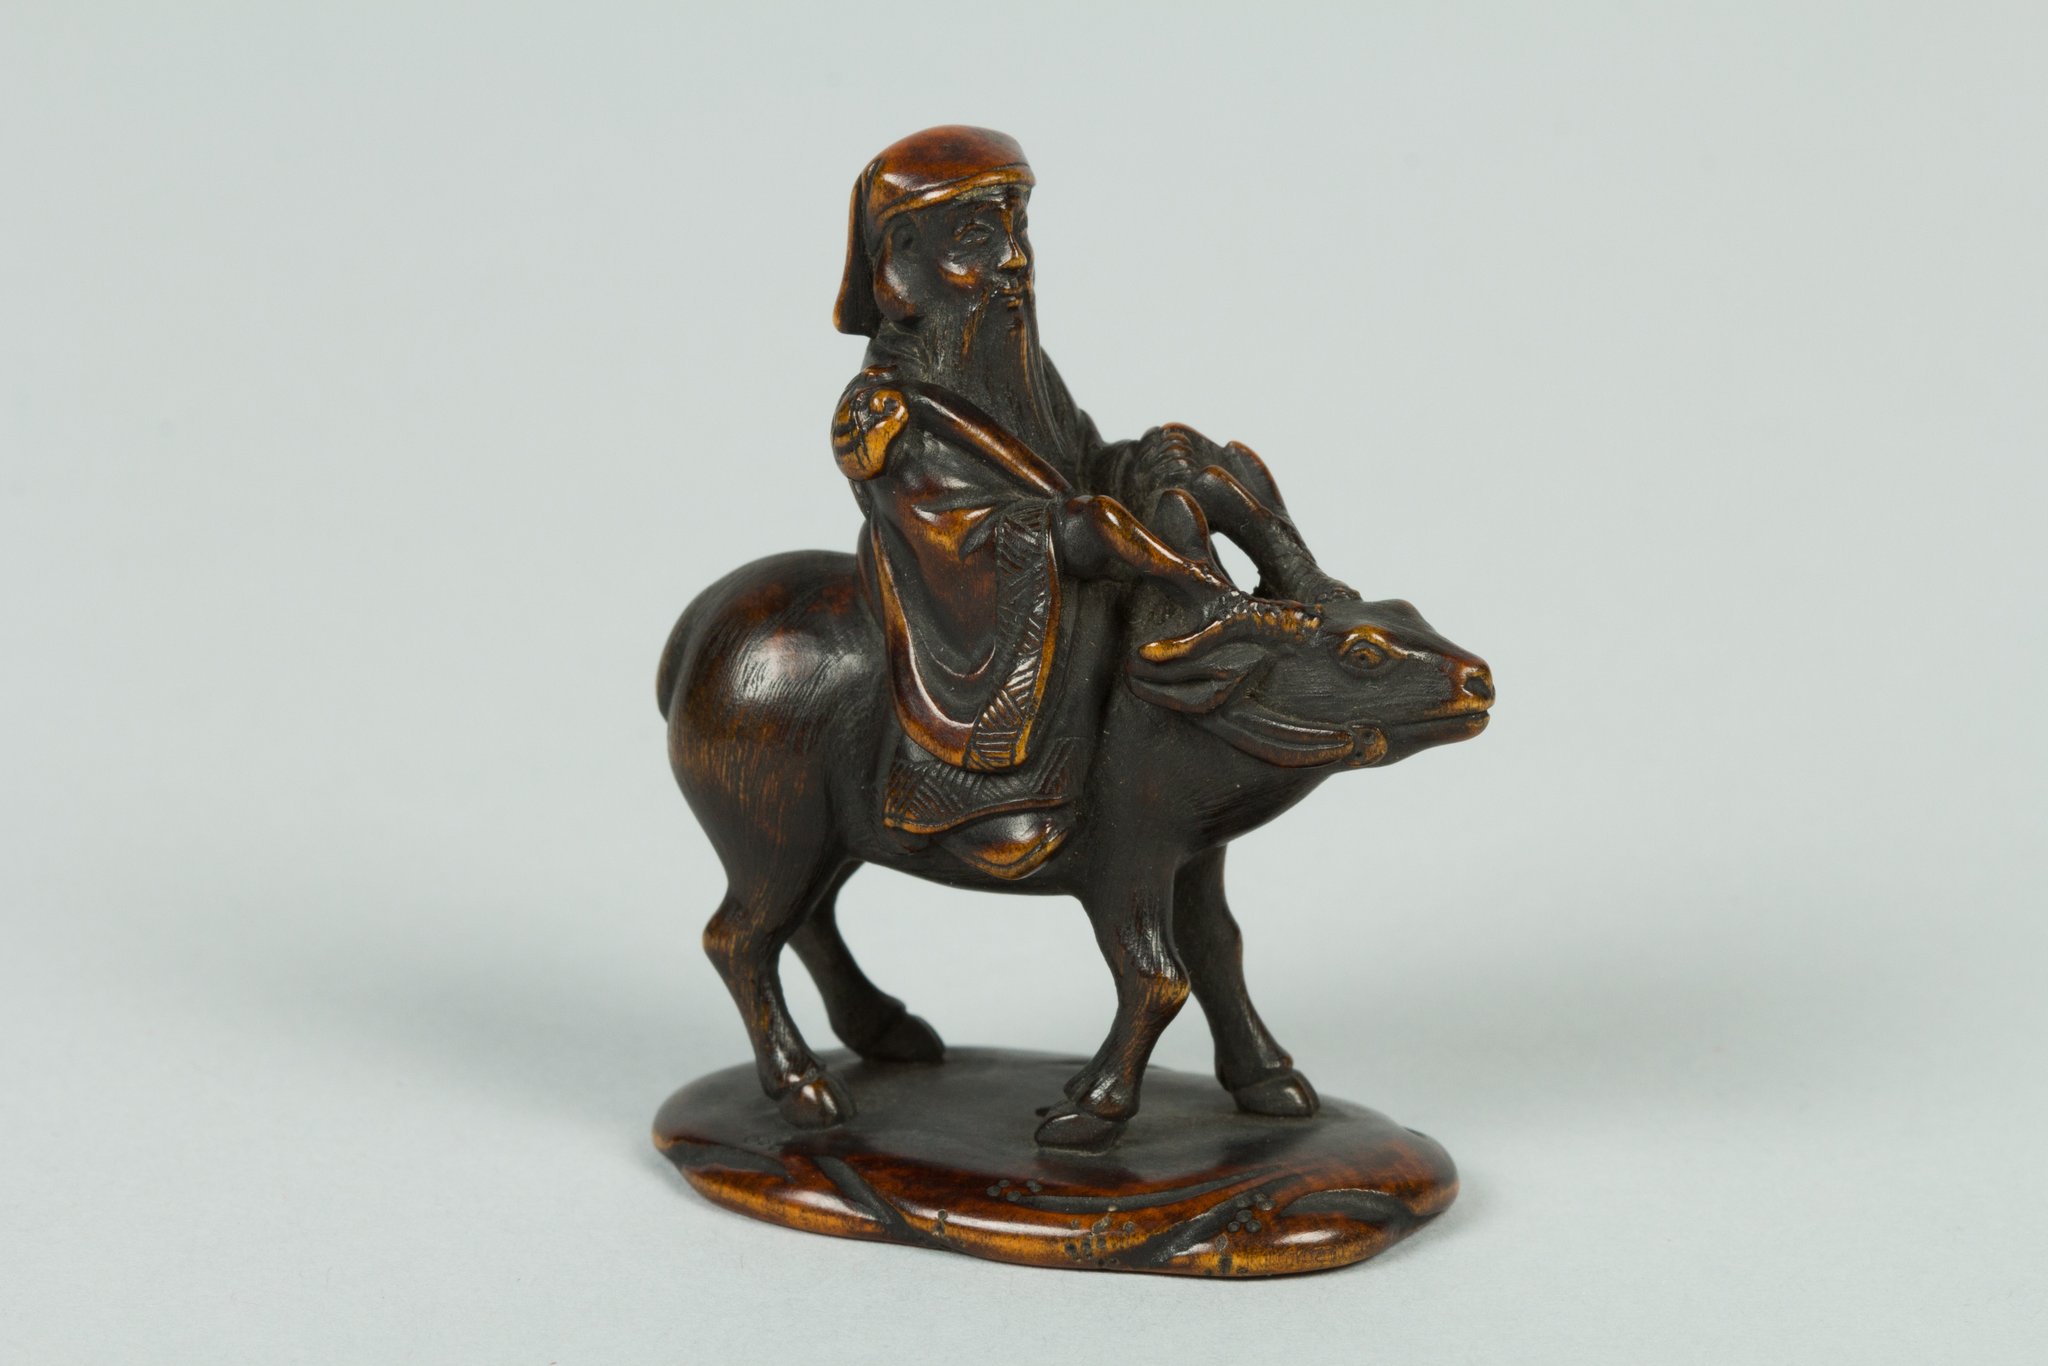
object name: netsuke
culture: japanese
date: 1801-1900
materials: wood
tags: men,buffalos